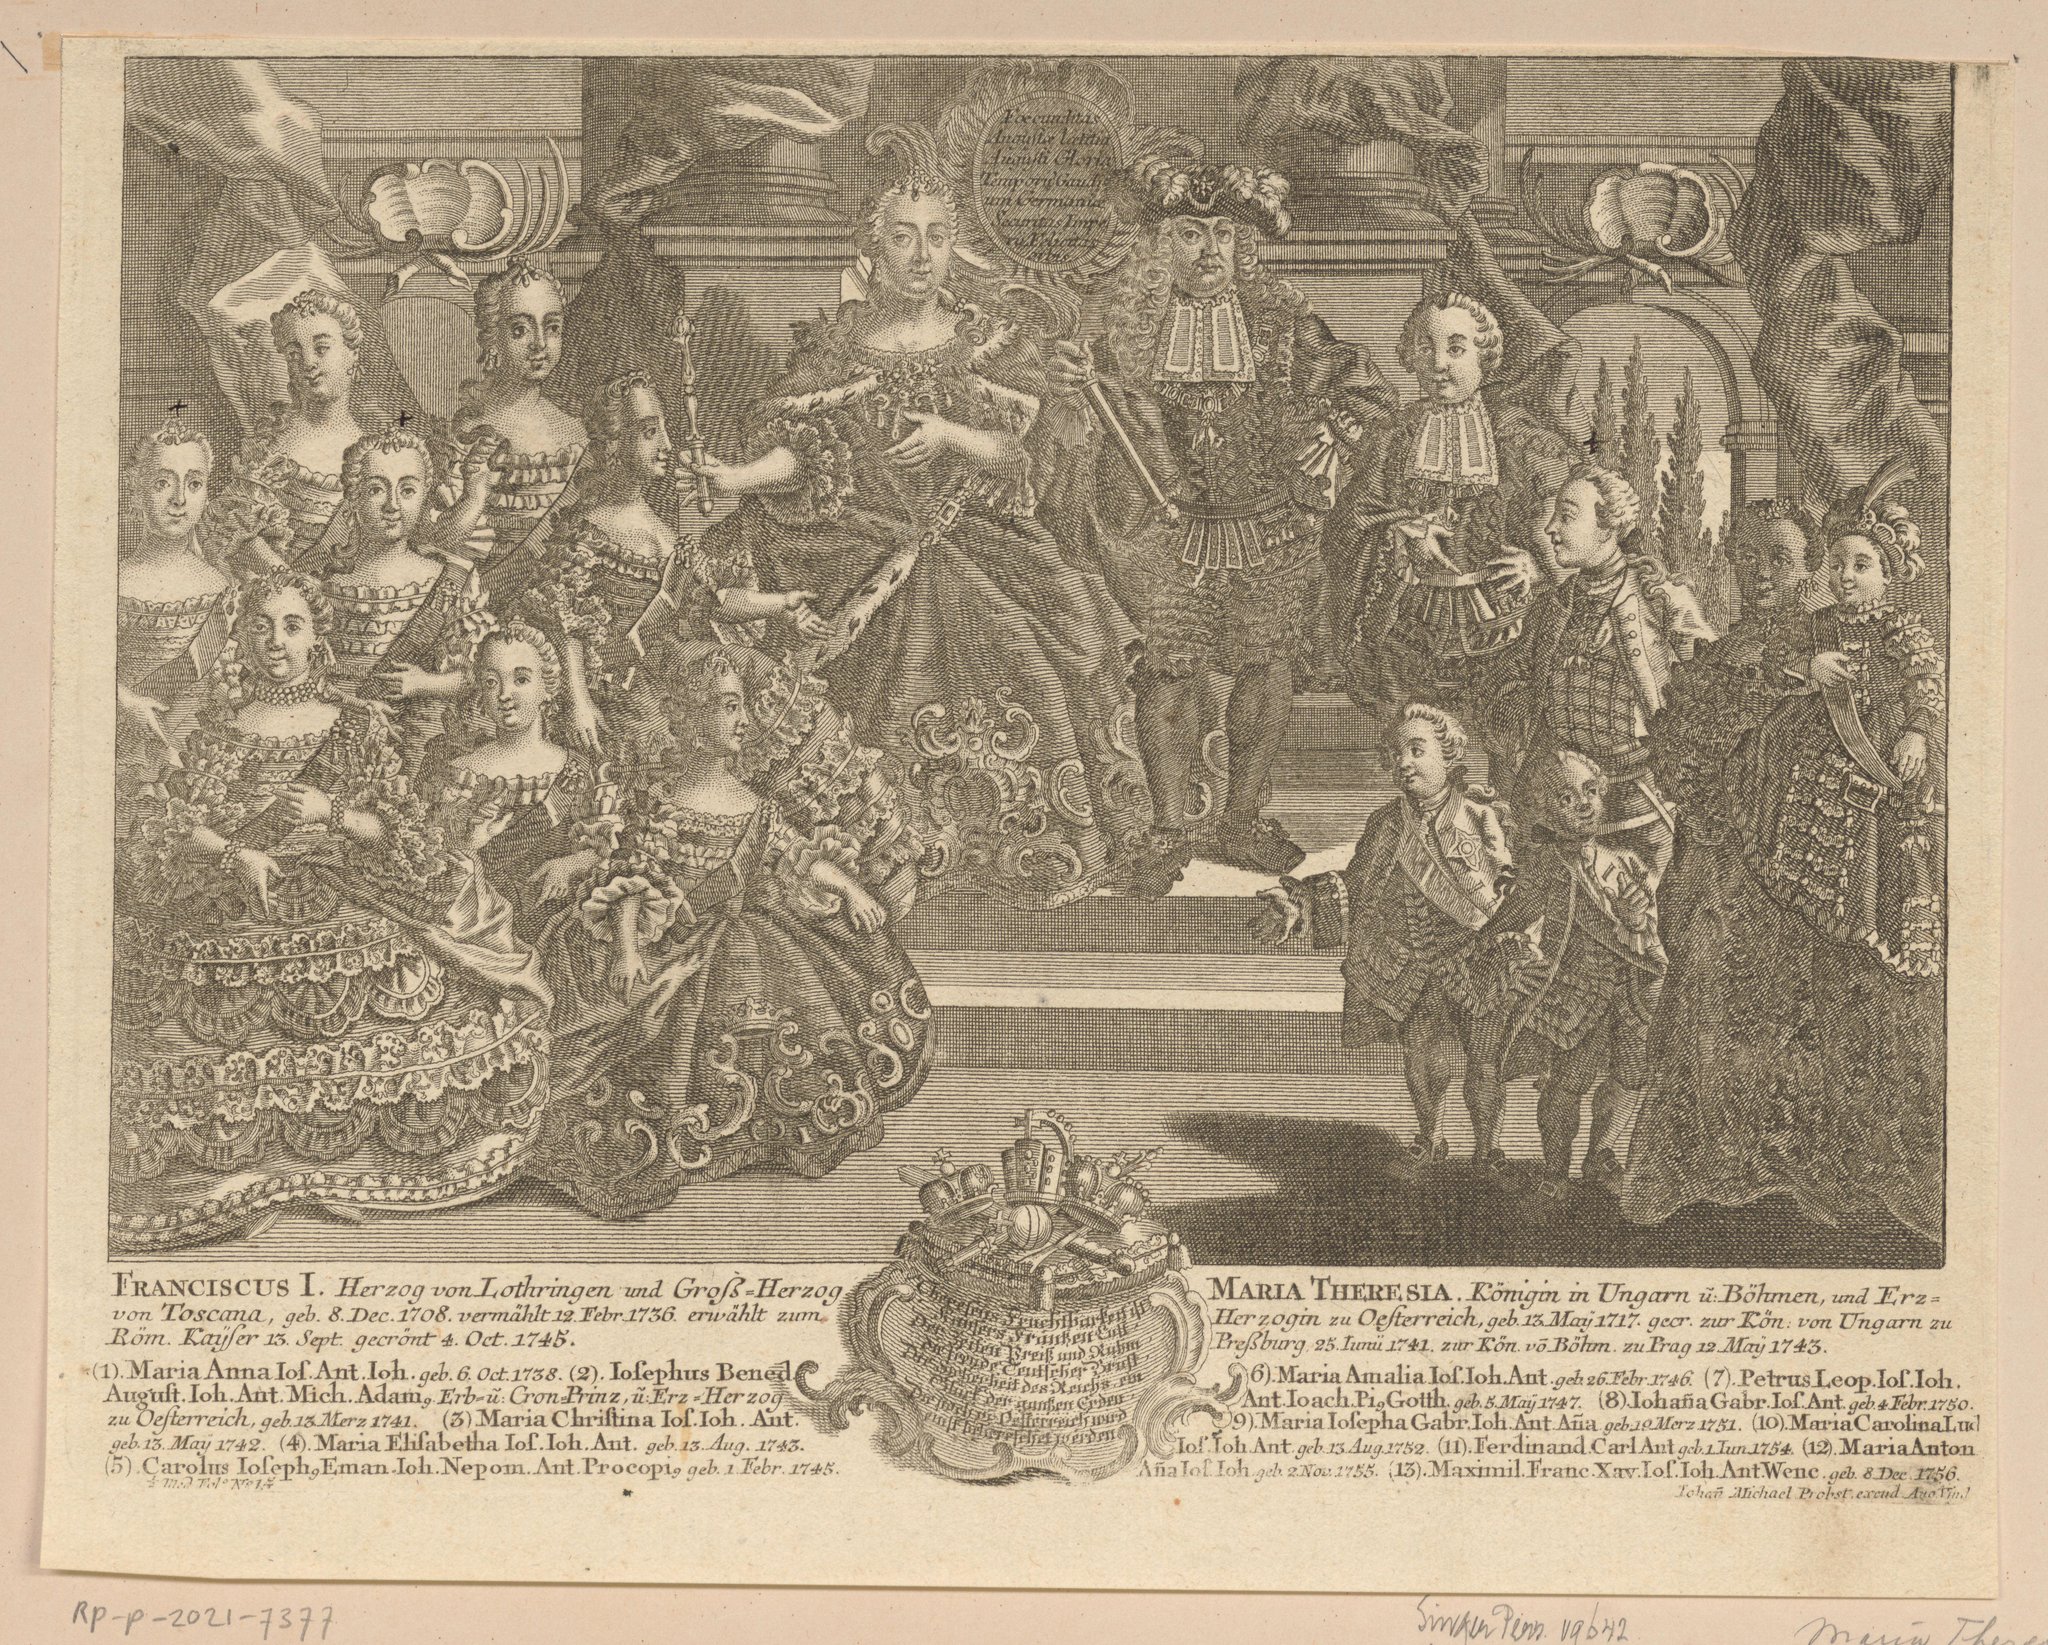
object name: print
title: Groepsportret van Maria Theresia van Oostenrijk, Frans I Stefan en dertien van hun kinderen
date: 1756-1761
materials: paper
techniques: etching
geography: germany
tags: maria carolina van oostenrijk, maria christina van oostenrijk (1742-1798), maria theresia (rooms-duits keizerin), jozef ii (duits keizer), maria amalia (aartshertogin van oostenrijk), frans i stefan (duits keizer), paris, marie antoinette, vienna, leopold ii (keizer van oostenrijk), historical persons - bb - woman, historical persons, emperor - bb - female ruler